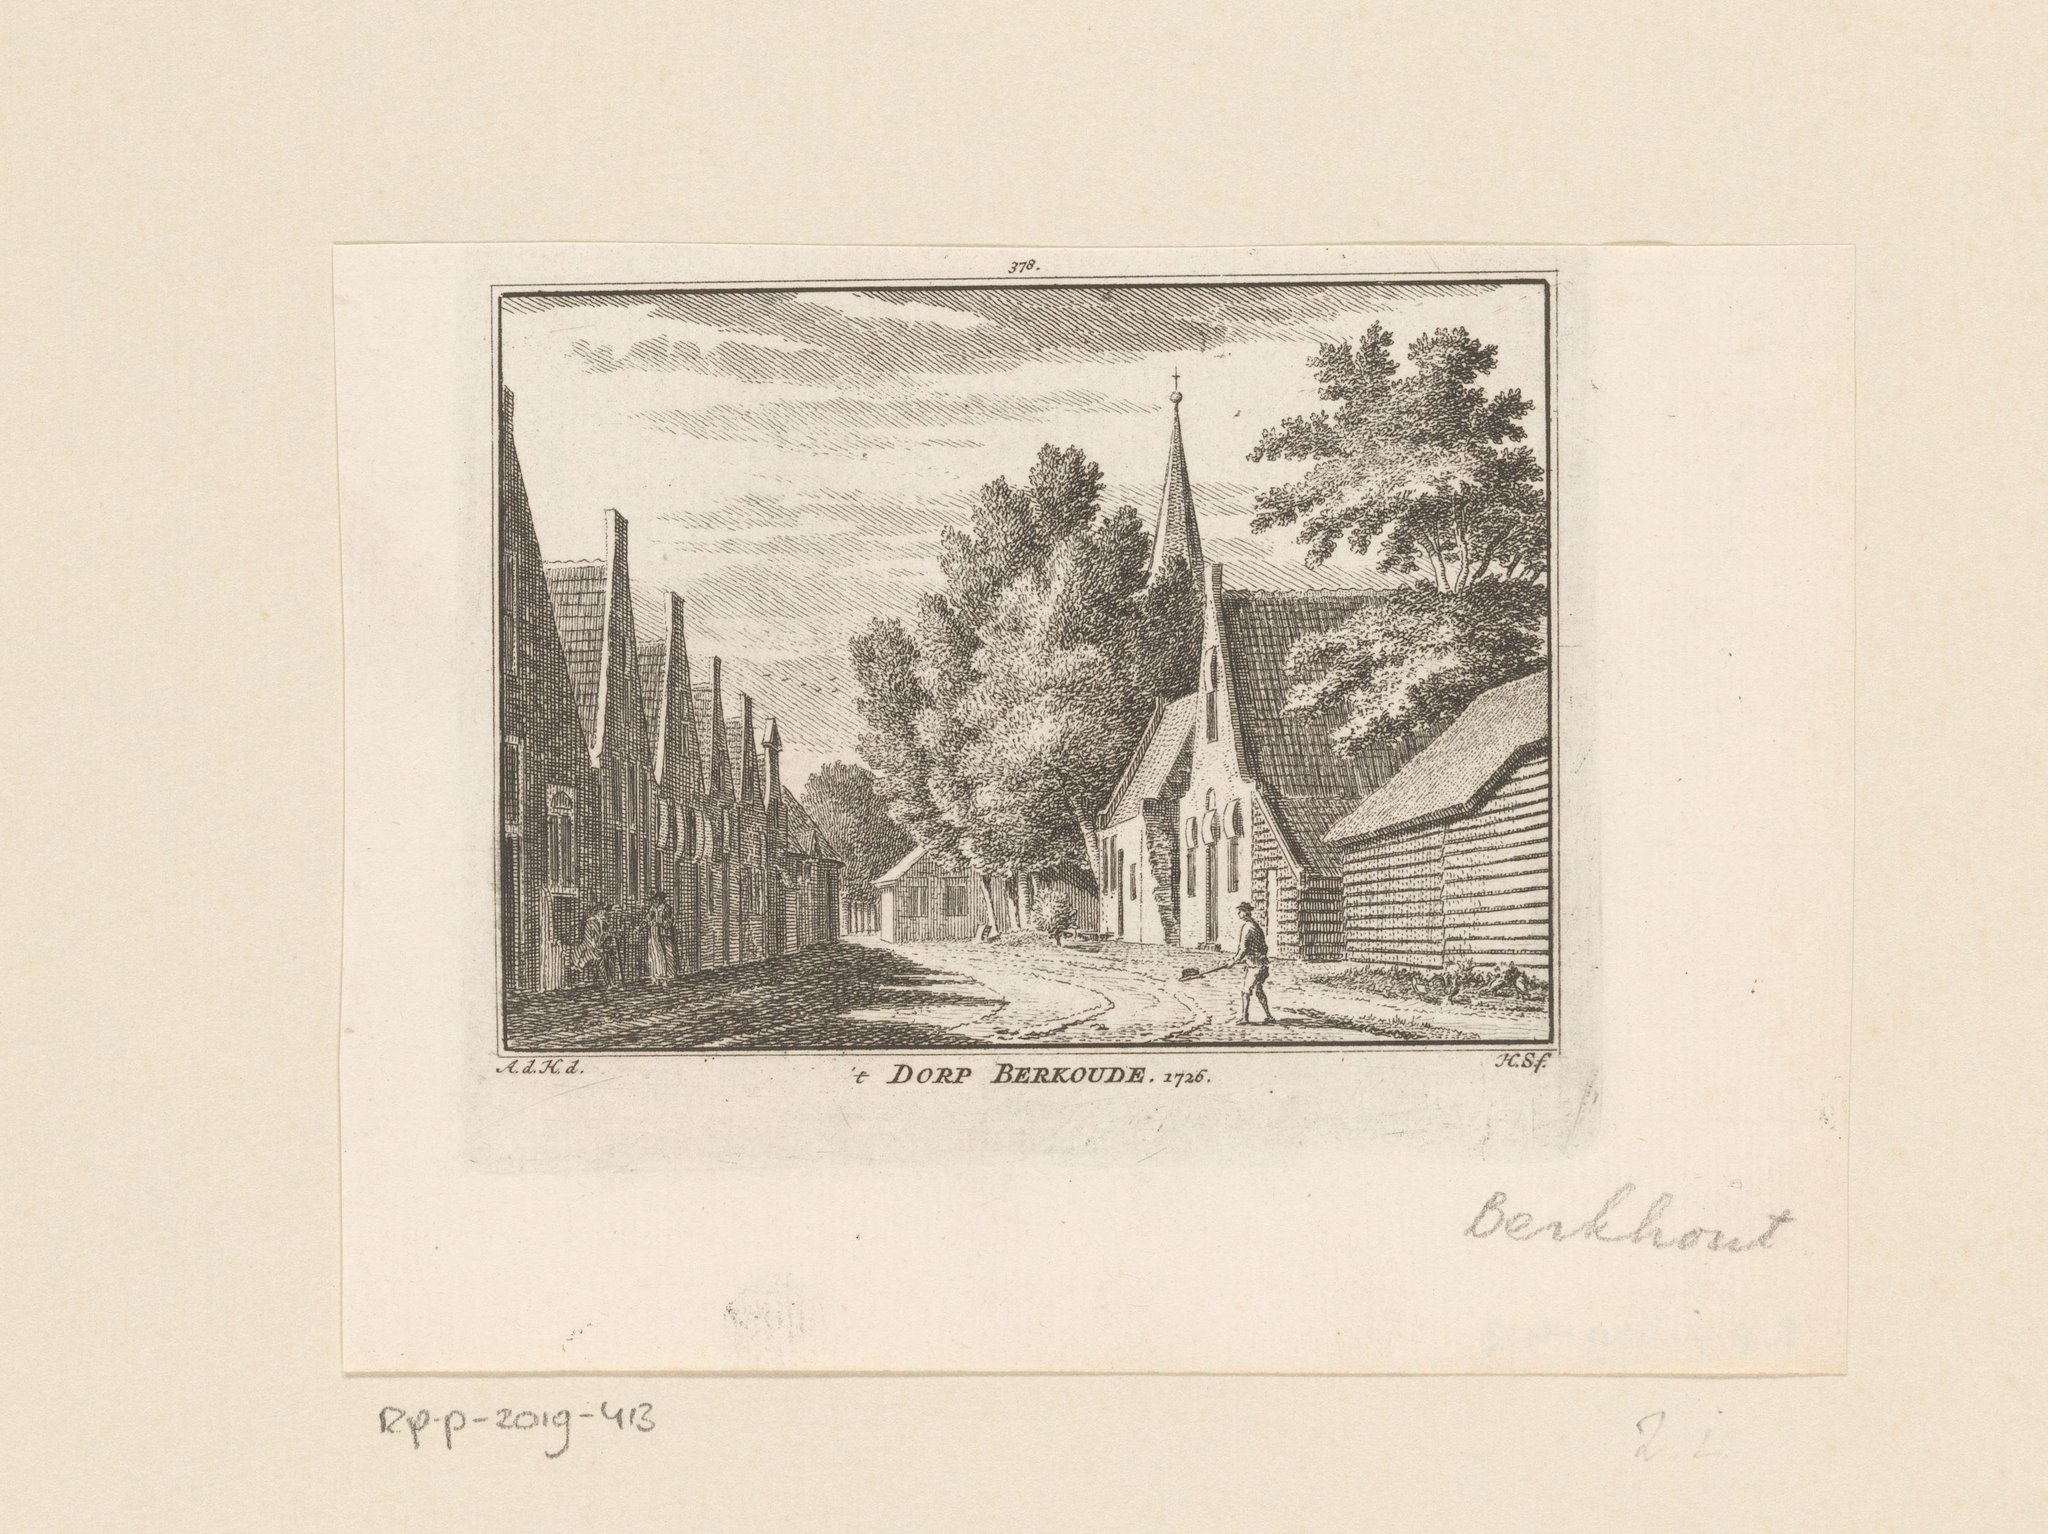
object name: print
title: 't Dorp Berkoude. 1726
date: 1746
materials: paper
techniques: etching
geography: amsterdam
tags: village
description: Prent verschenen in: Het verheerlykt Nederland, of, Kabinet van hedendaagsche gezigten van steden, dorpen (...). Amsterdam: Isaak Tirion, 1746. De prent is het onderste deel van een plaat met twee dorpsgezichten.